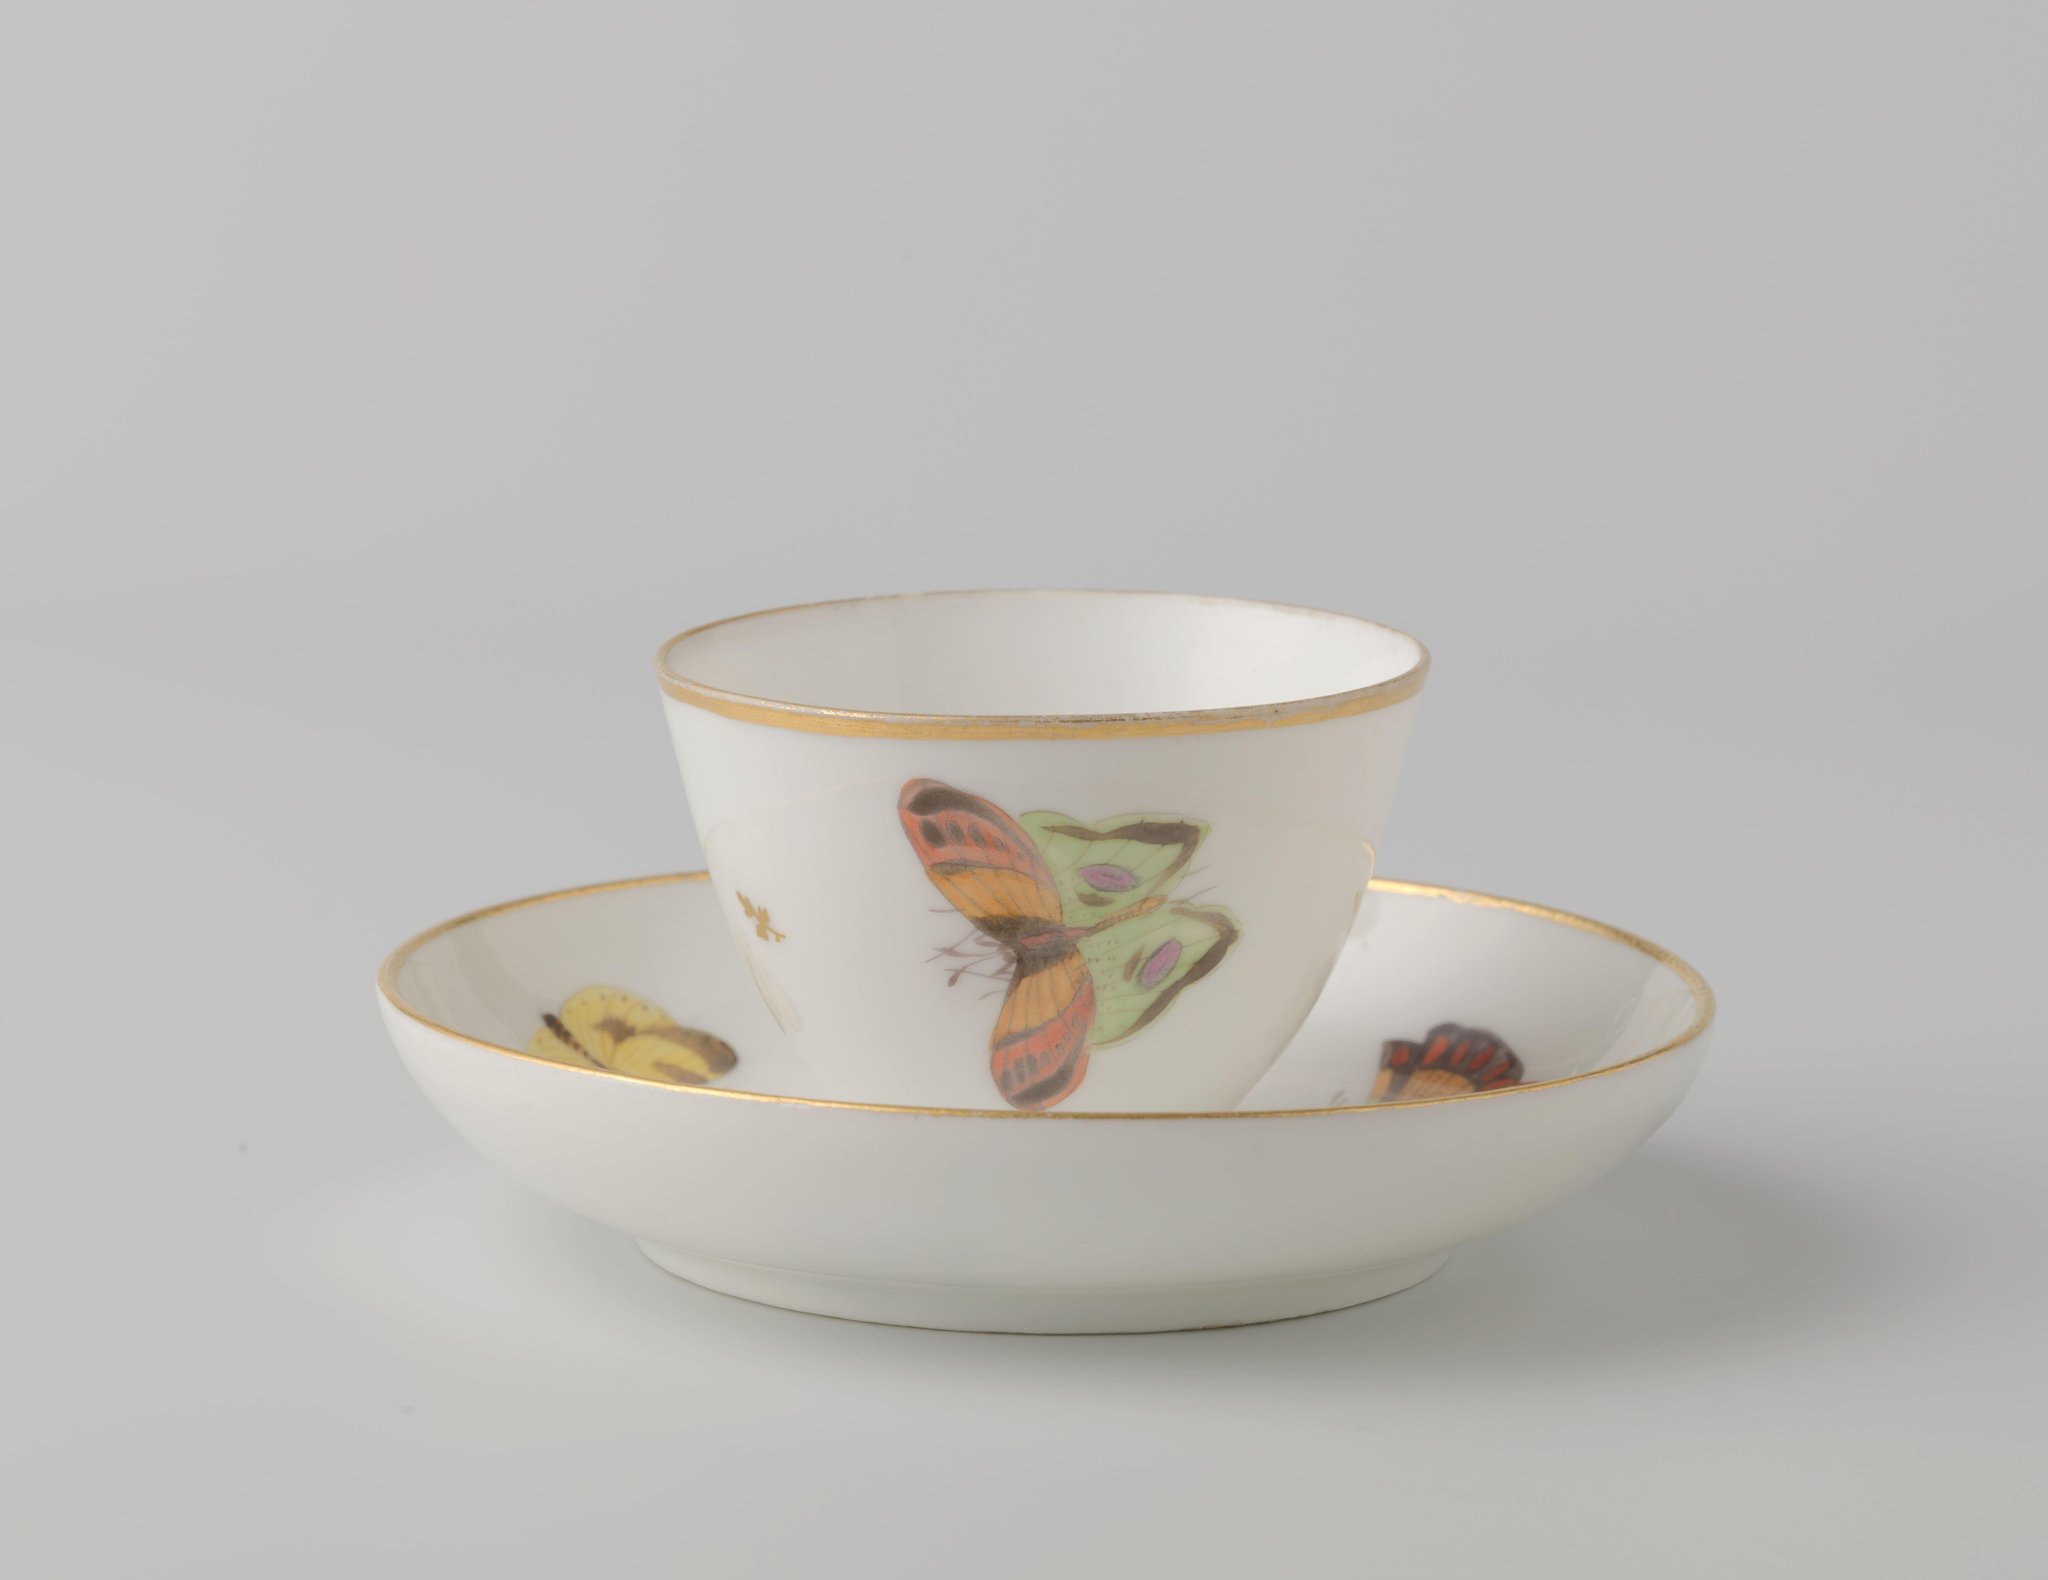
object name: platter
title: Schotel beschilderd met vlinders en libellen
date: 1784-1809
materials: porcelain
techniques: painted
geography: ouder-amstel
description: Schotel veelkleurig beschilderd met vlinders en libellen. Gemerkt: Amstel.